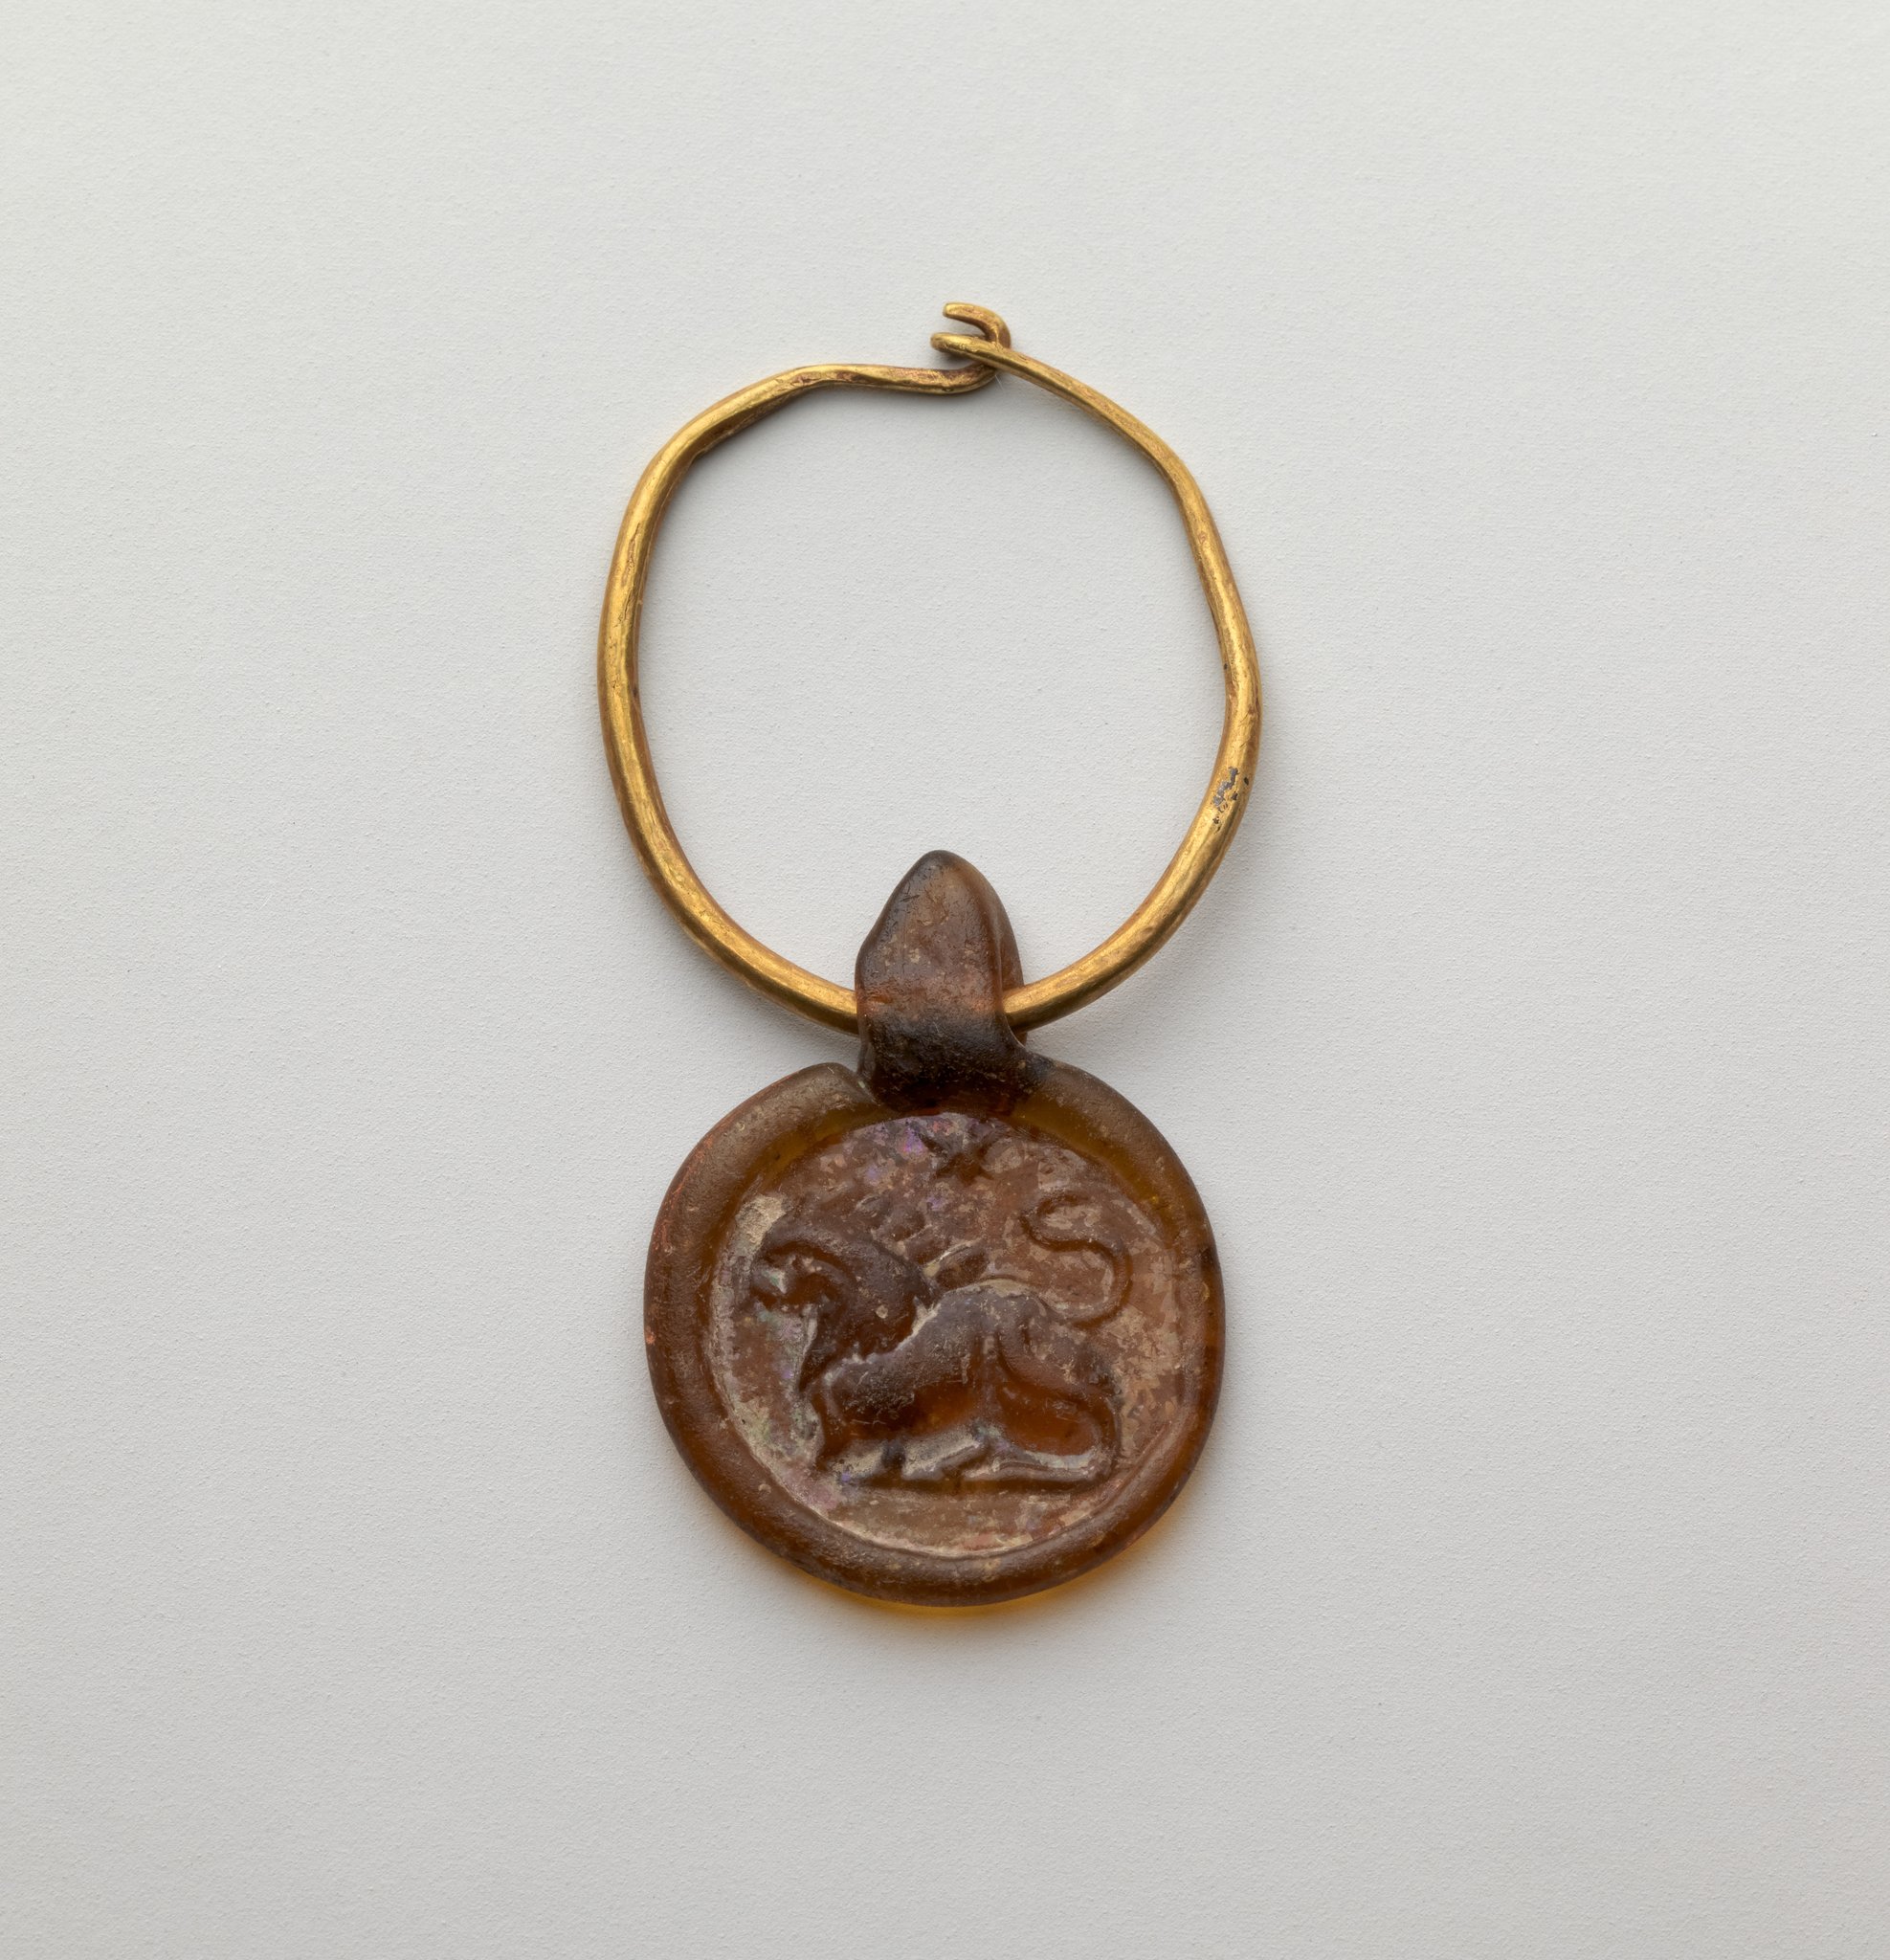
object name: pendant, stamped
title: Gold hoop with glass pendant stamped disk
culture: roman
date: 367-500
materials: glass, gold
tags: animals